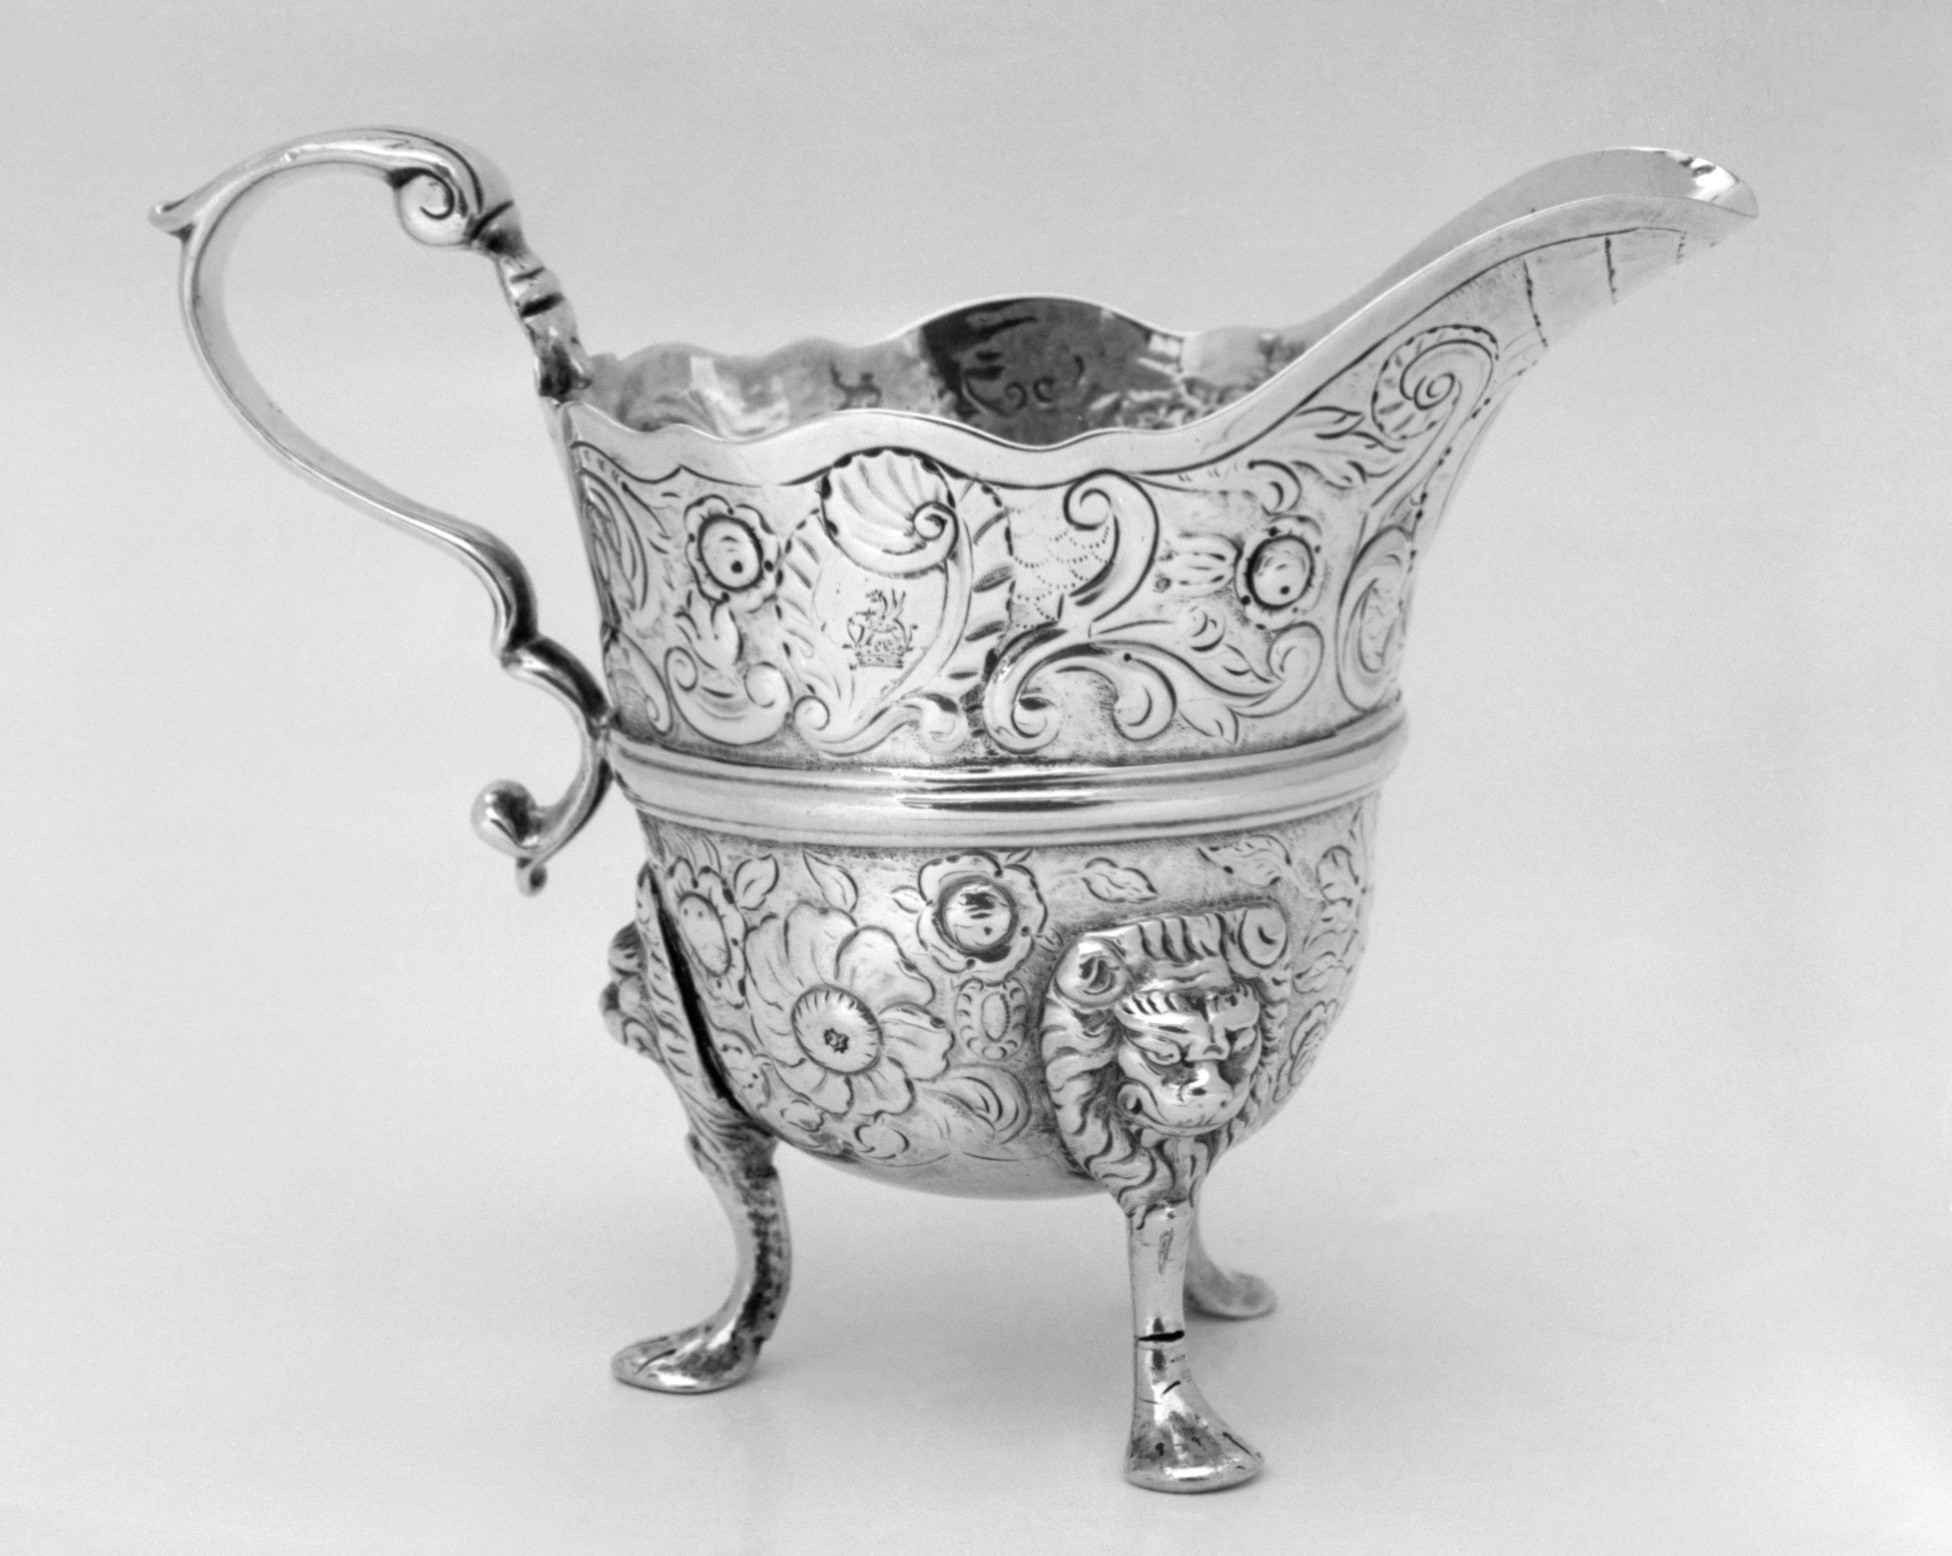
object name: cream jug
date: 1750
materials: silver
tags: flowers